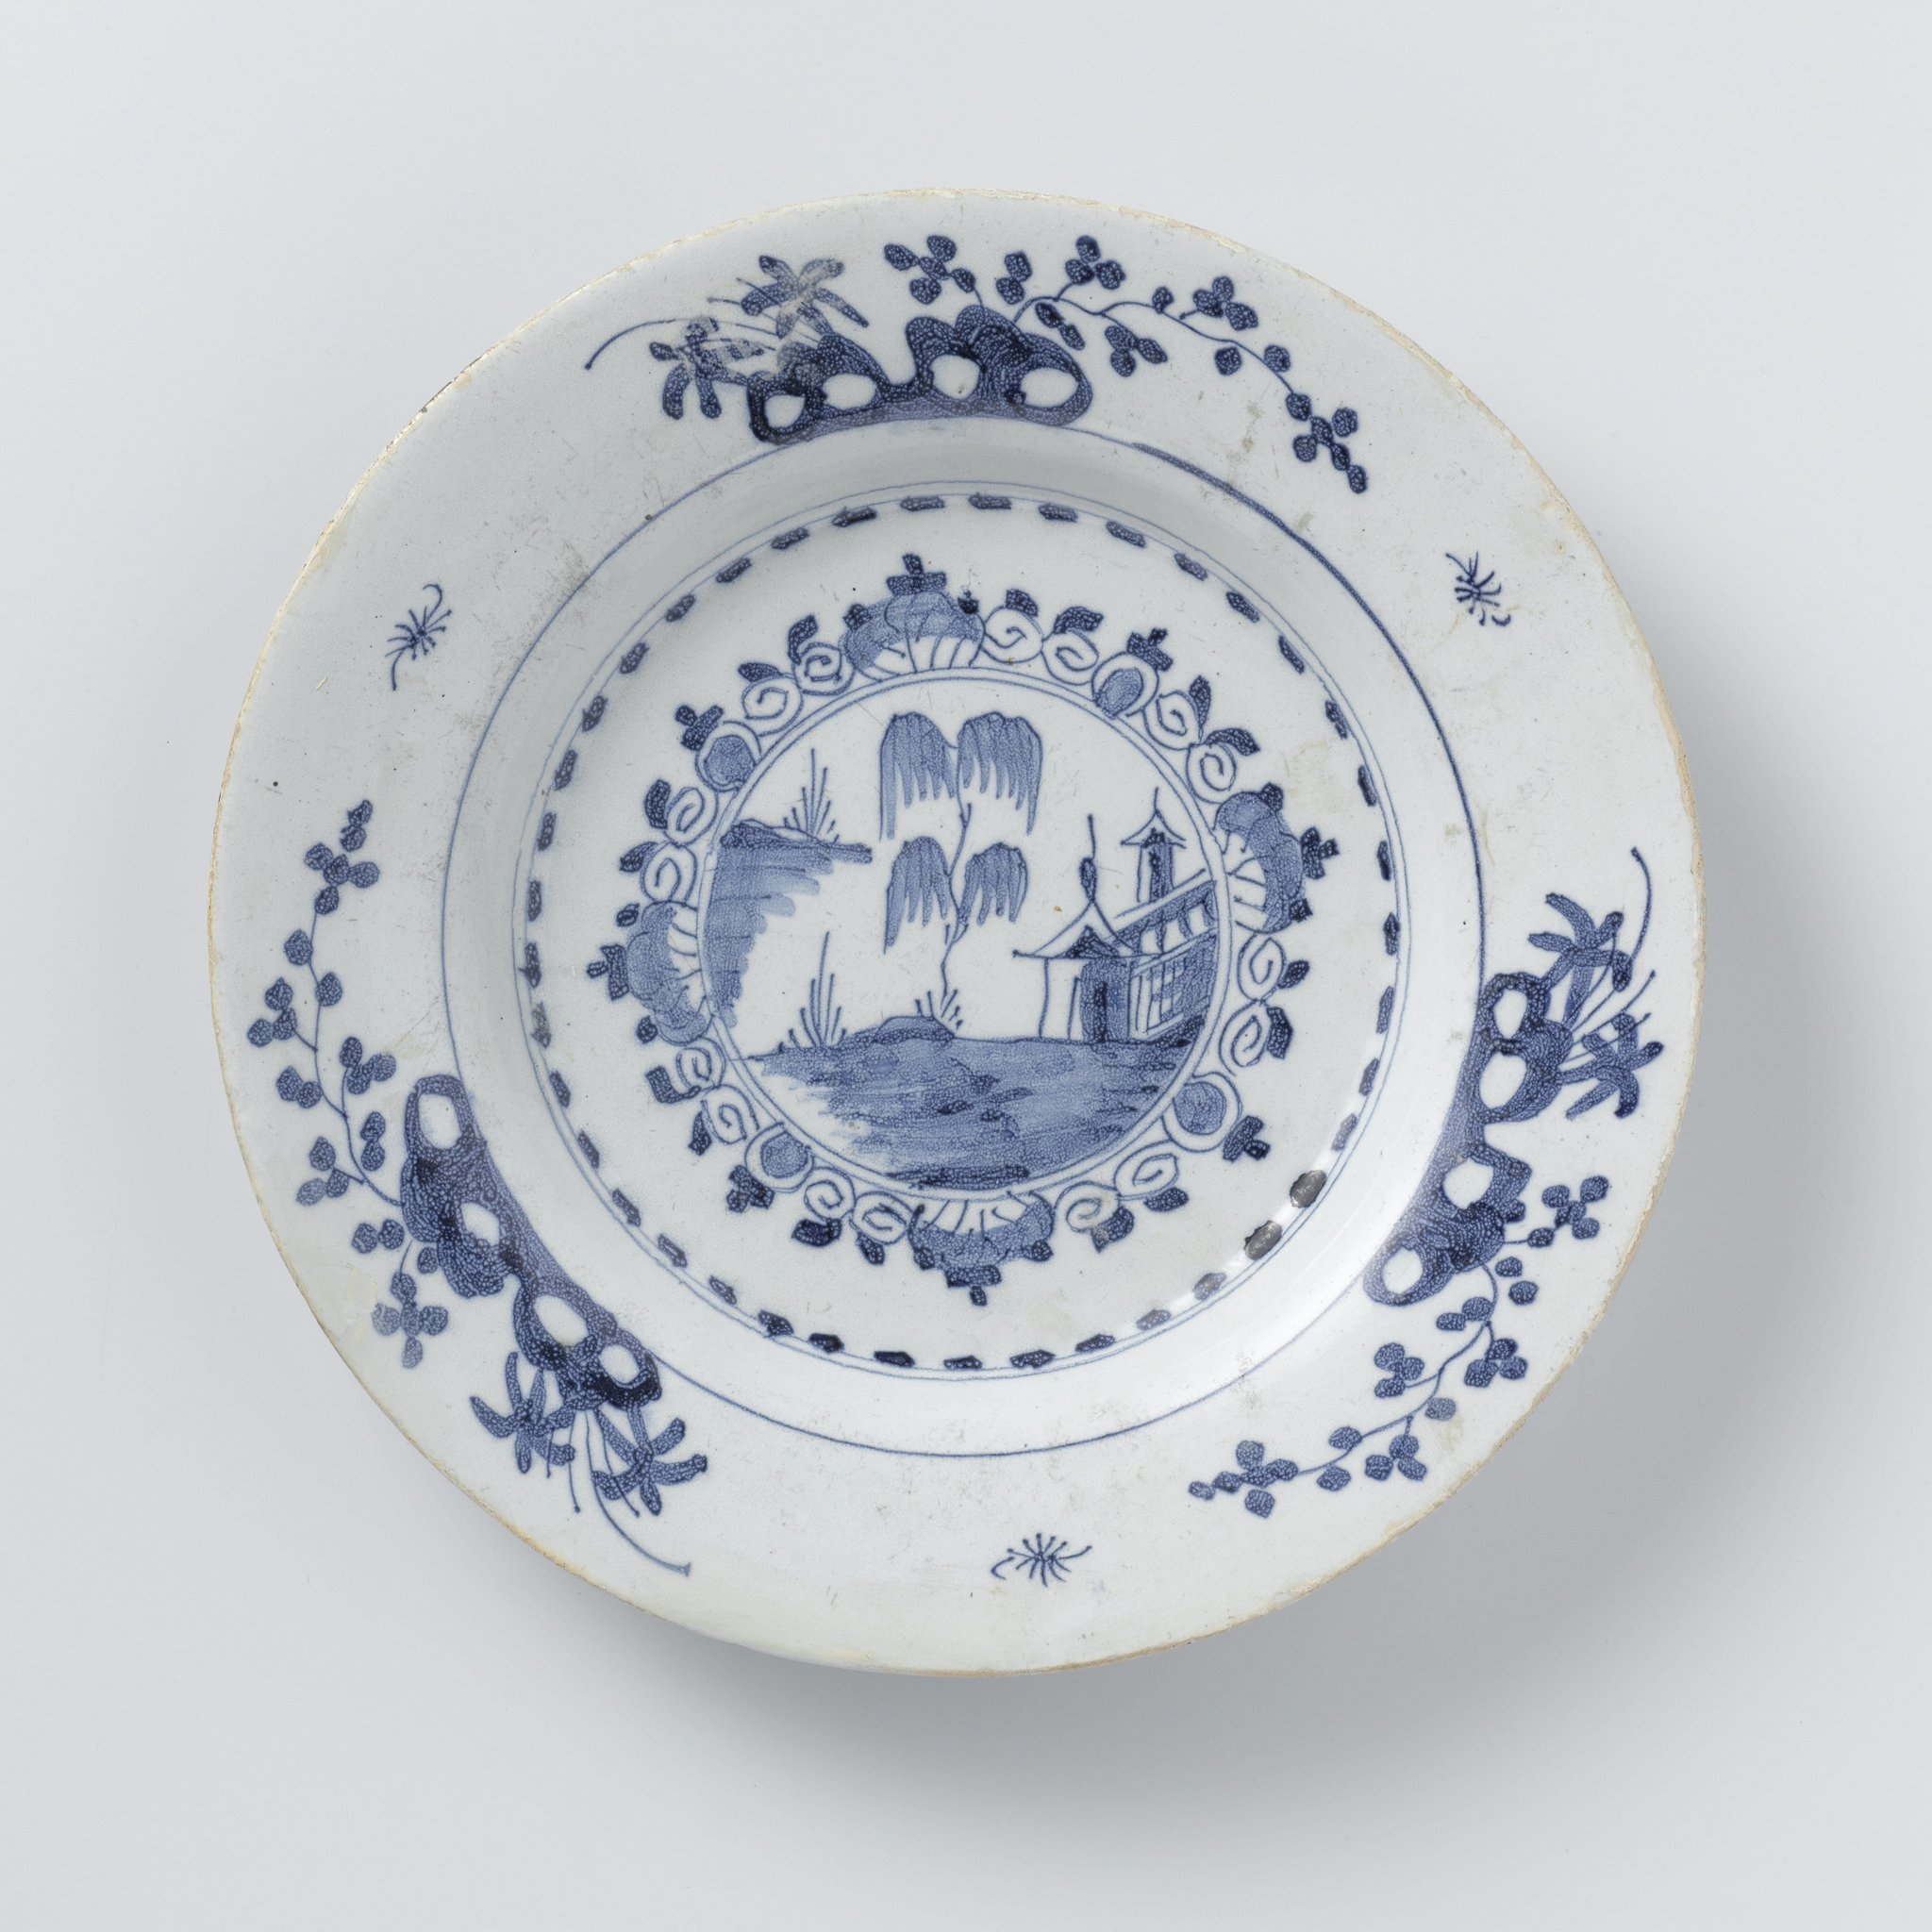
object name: plate dish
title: Bord van faience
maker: Anonymous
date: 1750-1780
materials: faience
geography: delft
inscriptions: inscription: ‘1,-’, seal: ‘2231/ B’